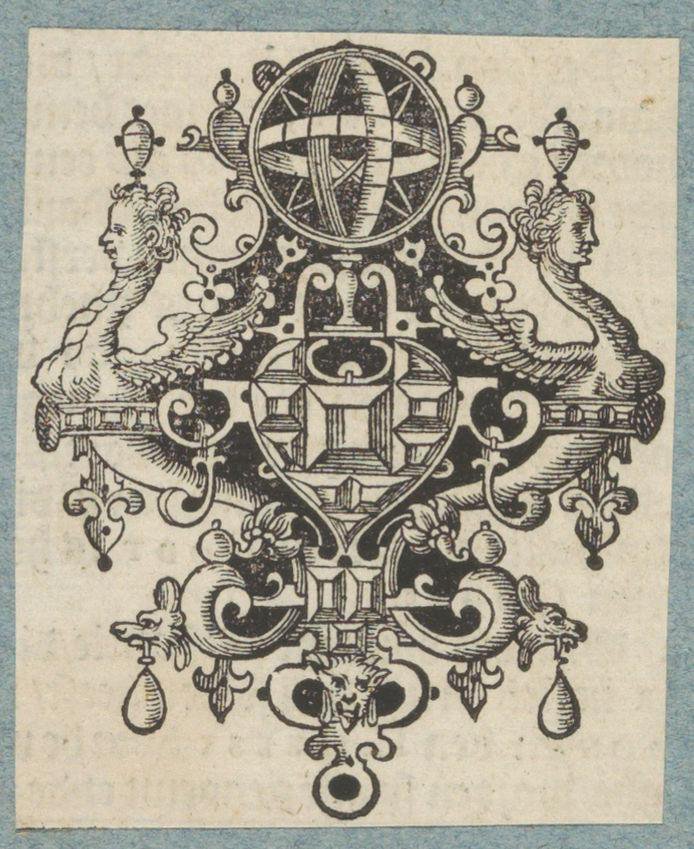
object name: book illustration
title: Ornament met edelstenen en hemelglobe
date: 1597-1667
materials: paper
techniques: letterpress printing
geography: amsterdam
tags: ornamental decoration ~ printed matter, book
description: Afkomstig uit een van de uitgaven van P.J. Paets uit Amsterdam.